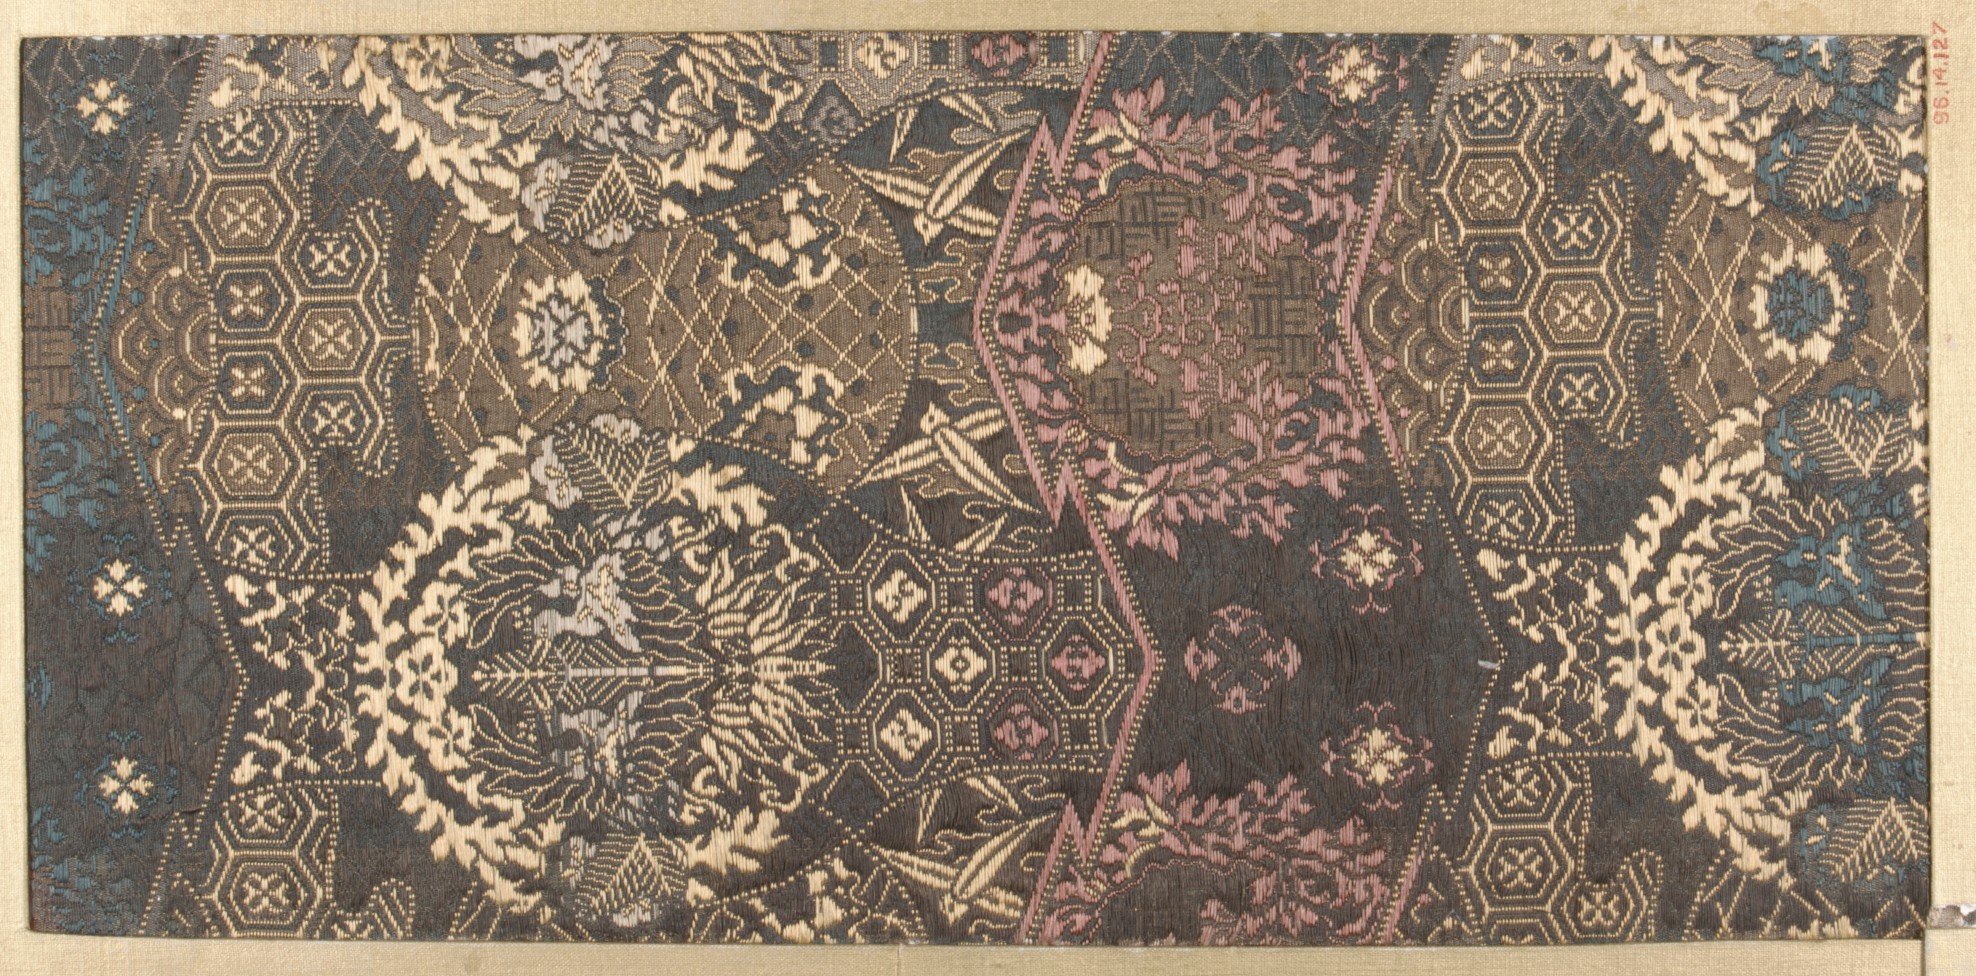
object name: piece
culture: japanese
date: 1701-1900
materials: silk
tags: leaves